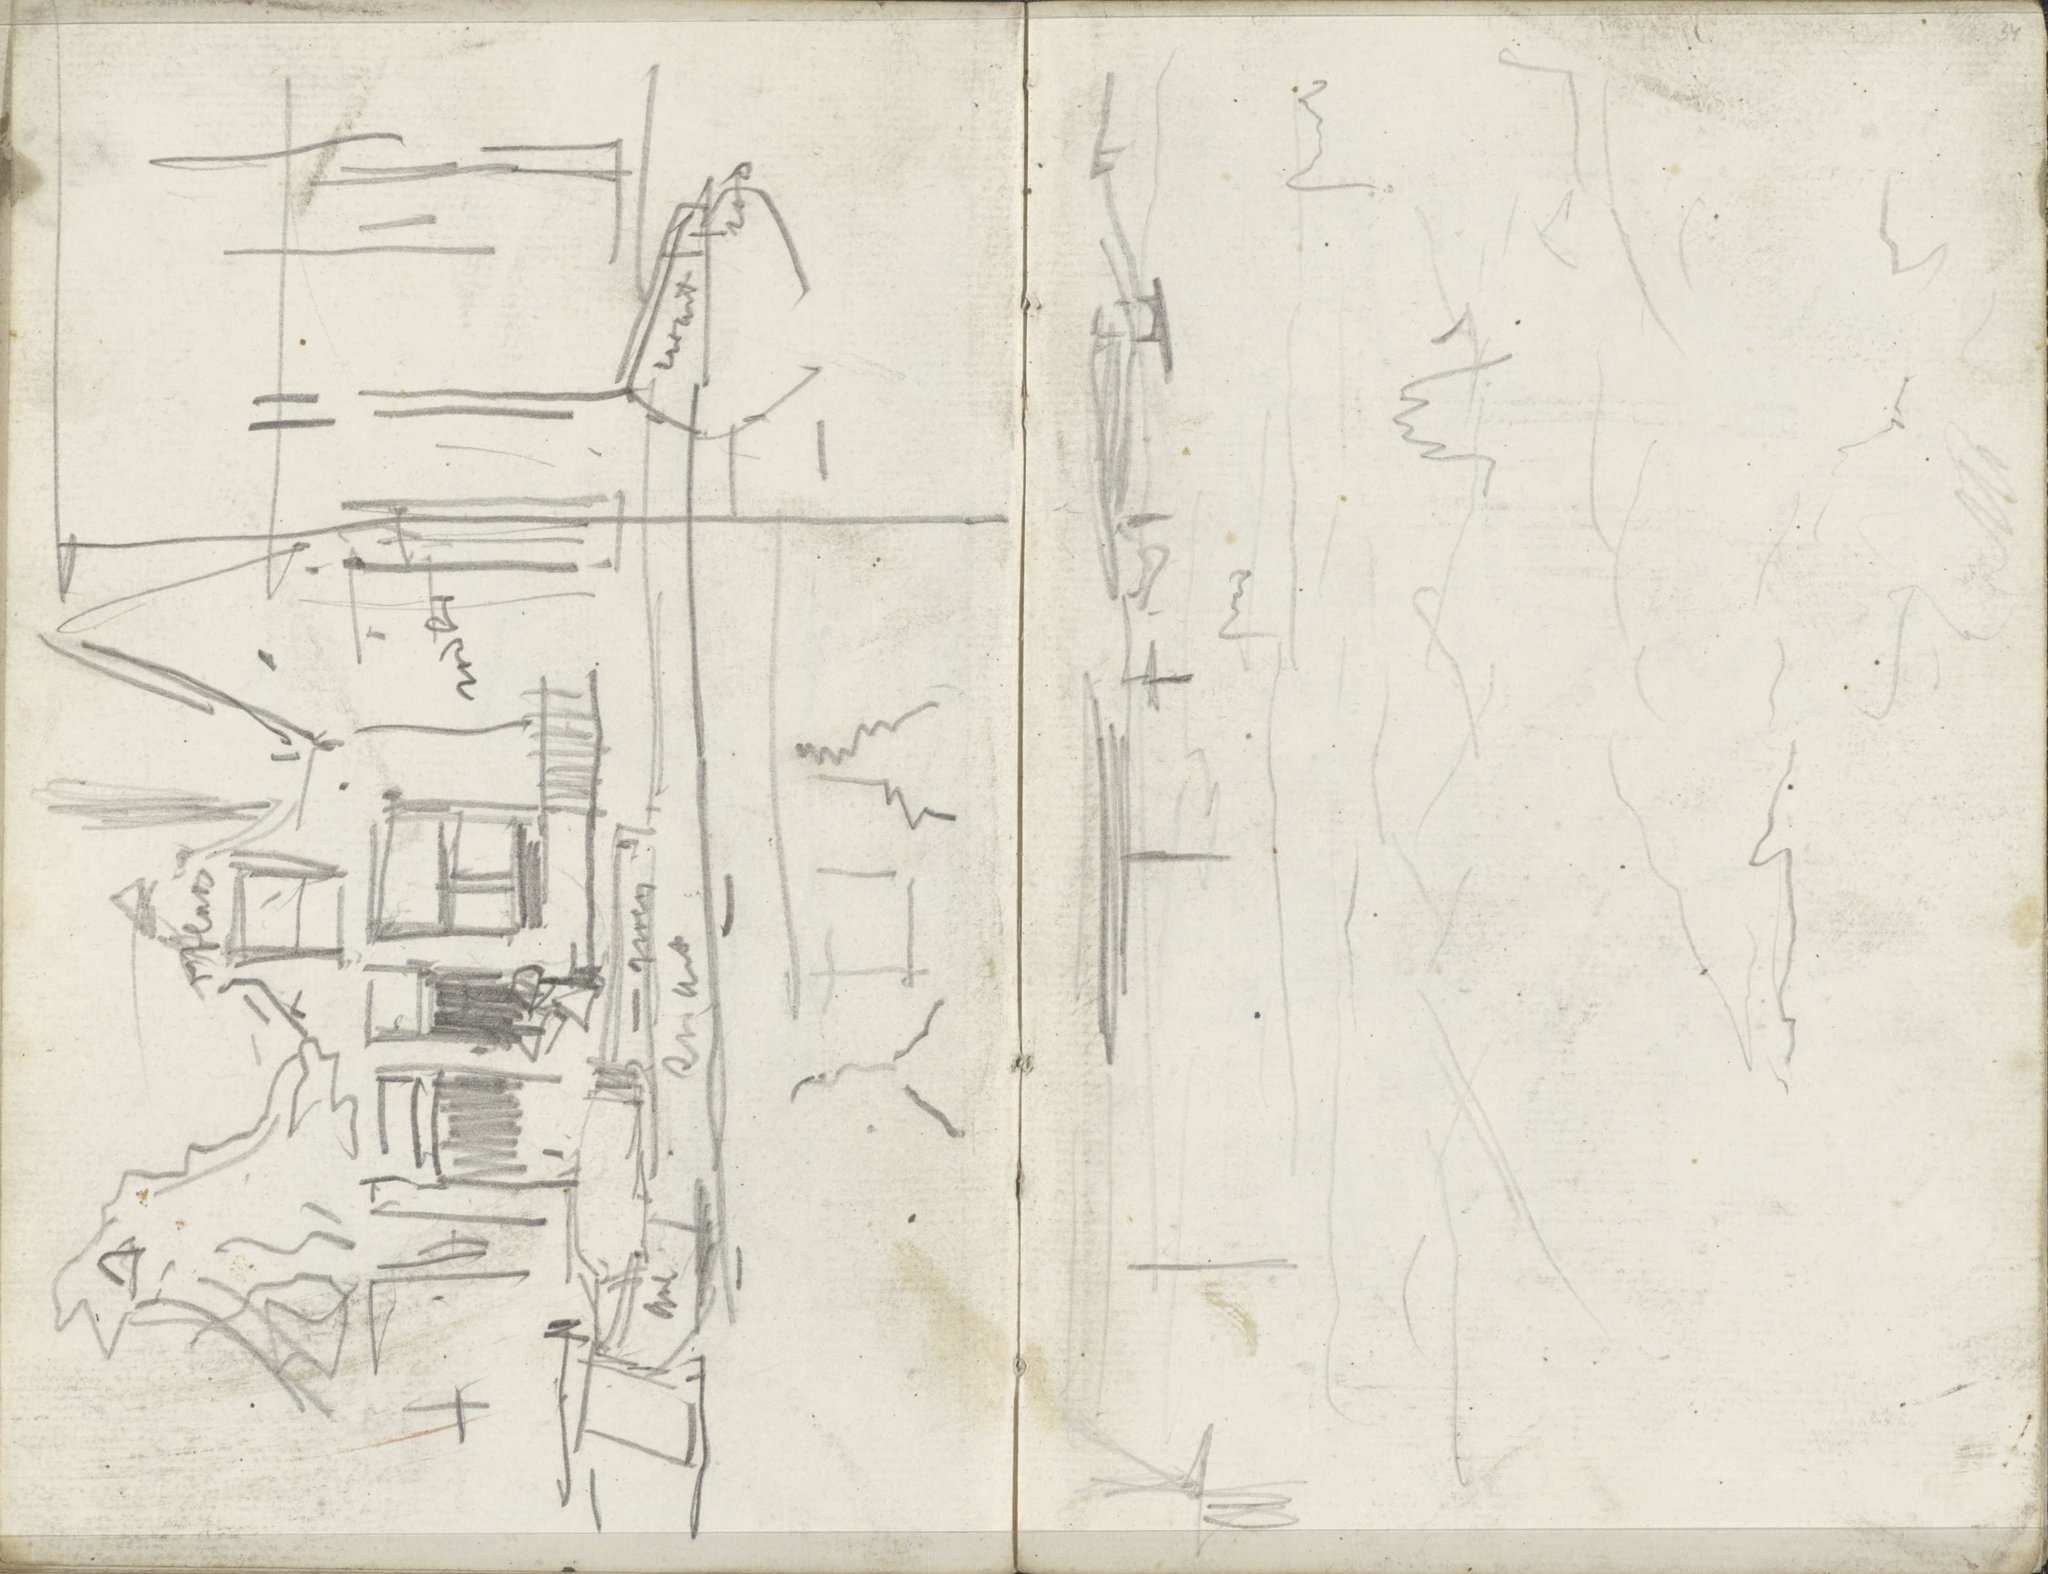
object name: sketchbook leaf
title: Bebouwing, mogelijk langs het water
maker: george hendrik breitner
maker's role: draughtsman, painter, print maker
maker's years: 1857-1923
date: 1886-1898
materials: paper, pencil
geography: amsterdam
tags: canals, waters (in city), civic architecture; edifices; dwellings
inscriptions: kleurnotitie, handgeschreven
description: Pagina 33 en pagina 34 uit een schetsboek met 21 bladen.